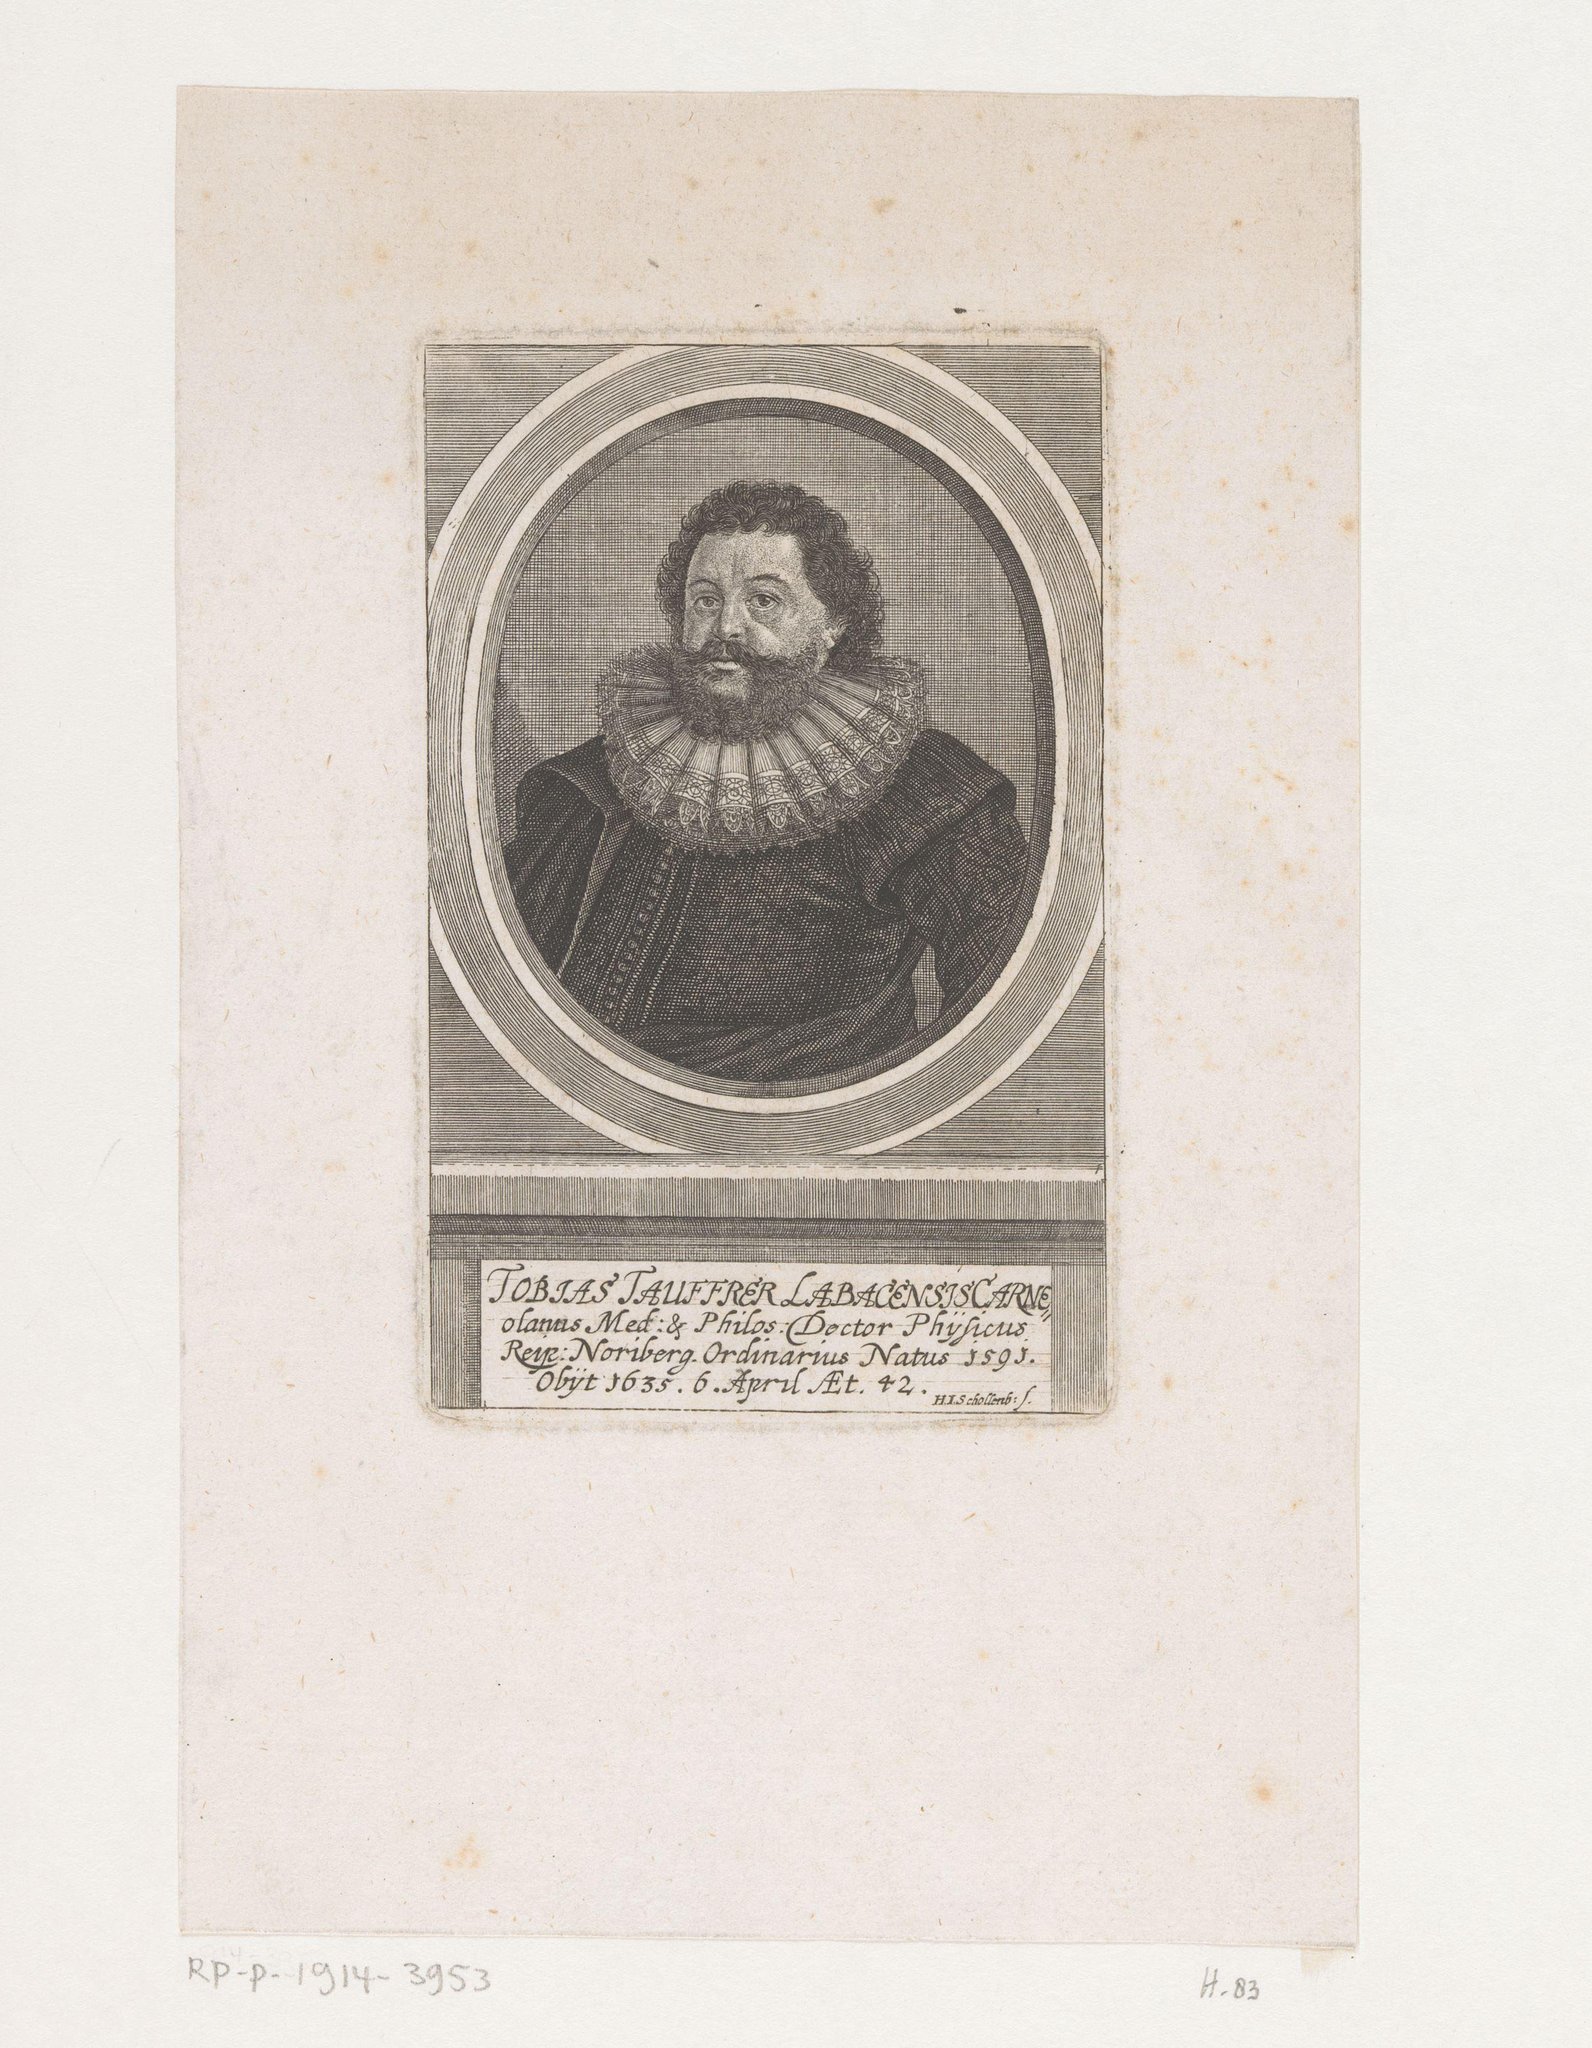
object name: print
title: Portret van Tobias Taufrer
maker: johann jacob schollenberger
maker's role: print maker, publisher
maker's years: 1646-1689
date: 1656-1689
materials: paper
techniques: engraving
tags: historical persons, counsellor, physician, doctor (+ portrait of scholar, scientist)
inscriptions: collector's mark: Lugt 2228